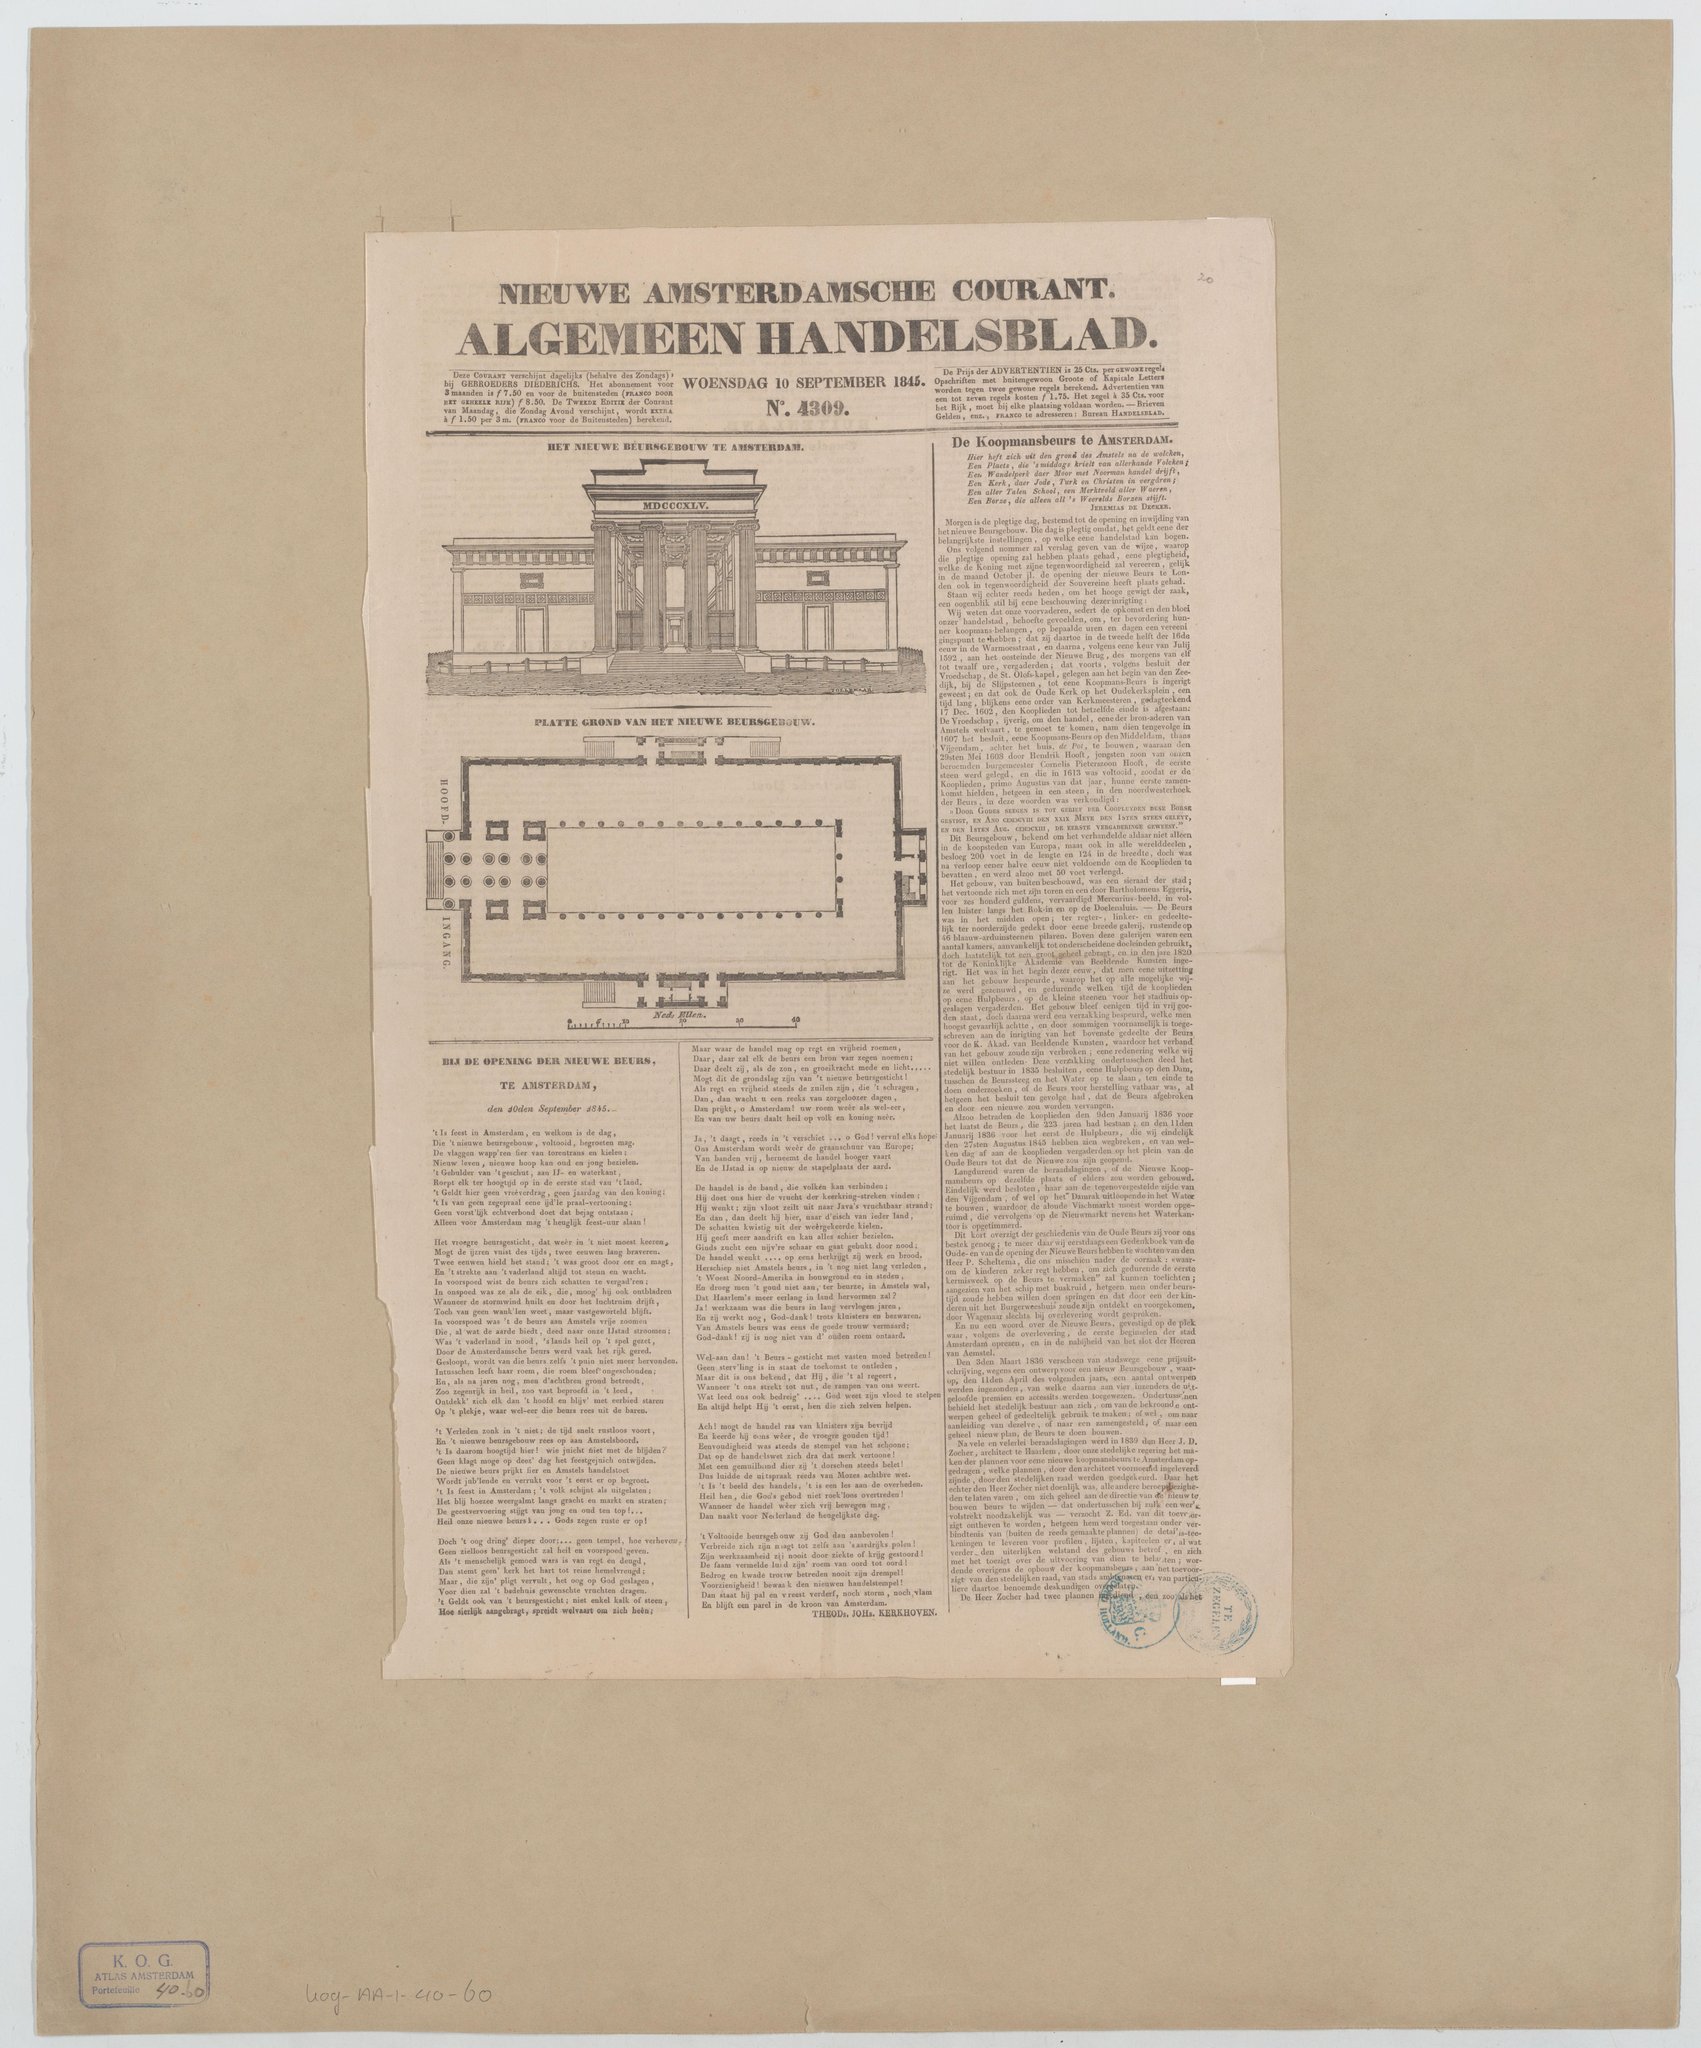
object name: print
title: Het nieuwe beursgebouw te Amsterdam / Platte grond van het nieuwe beursgebouw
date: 1845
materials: paper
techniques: letterpress printing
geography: amsterdam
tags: floor plan ~ architectural design or model, stock exchange, stock-market, front façade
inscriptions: collector's mark: Lugt 1641b, seal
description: Object bestaat uit een bifolium. Onderwerpsrubriek binnen de Atlas Amsterdam: Handel en Zeevaart: Hulpbeurs op de Dam en Beurs (Dam).